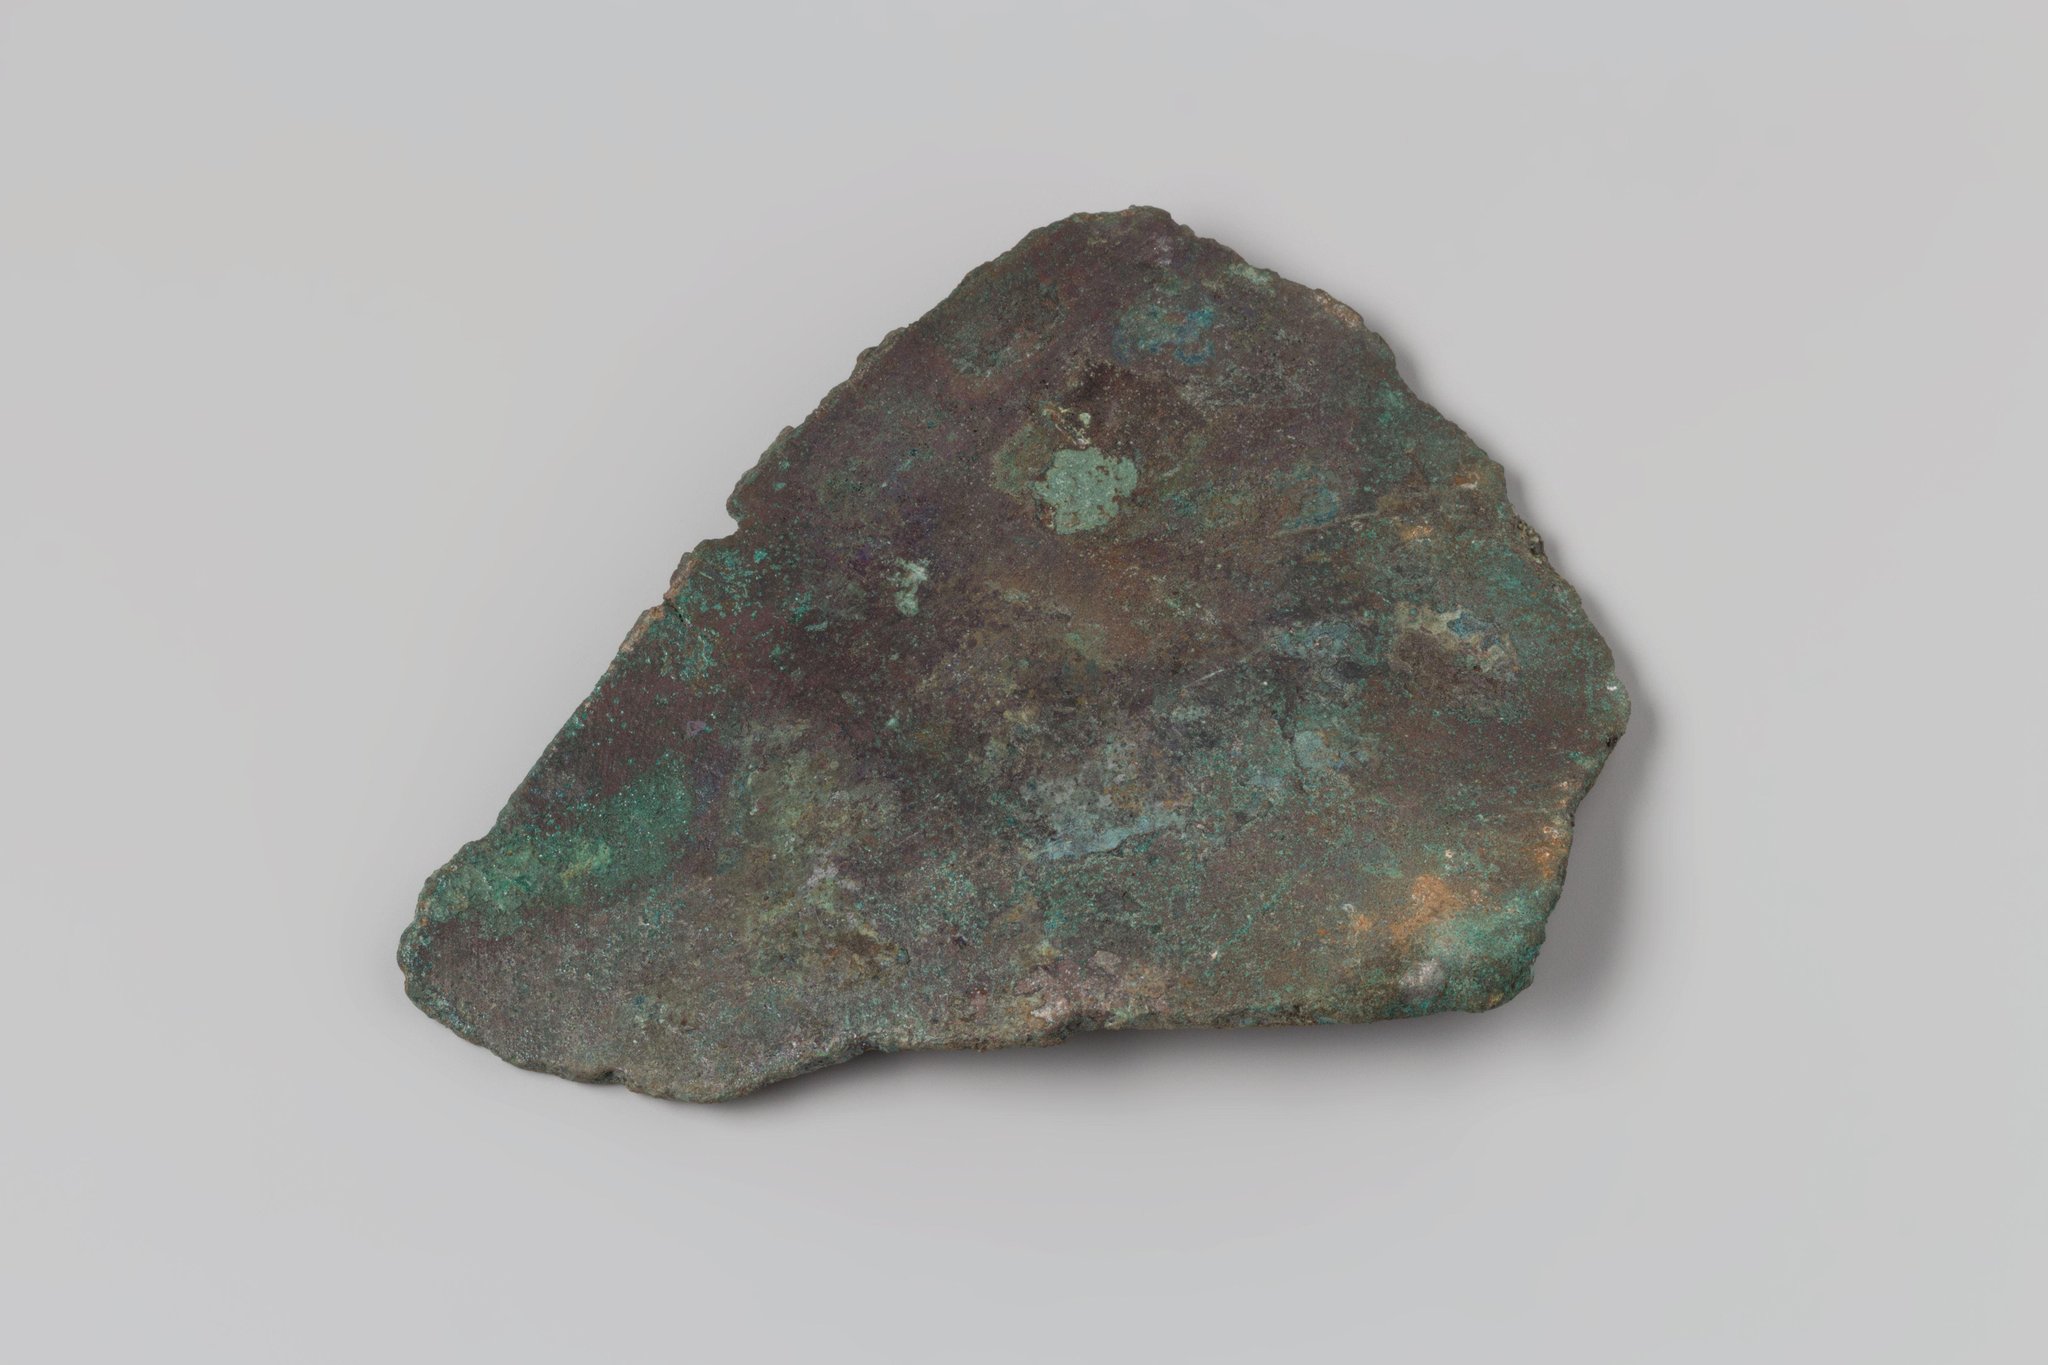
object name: scheepswrakvondst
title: Fragment van koper uit het wrak van de Oost-Indiëvaarder Hollandia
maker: Anonymous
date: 1700-1743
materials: copper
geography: netherlands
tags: verenigde oostindische compagnie, hollandia (schip), annet